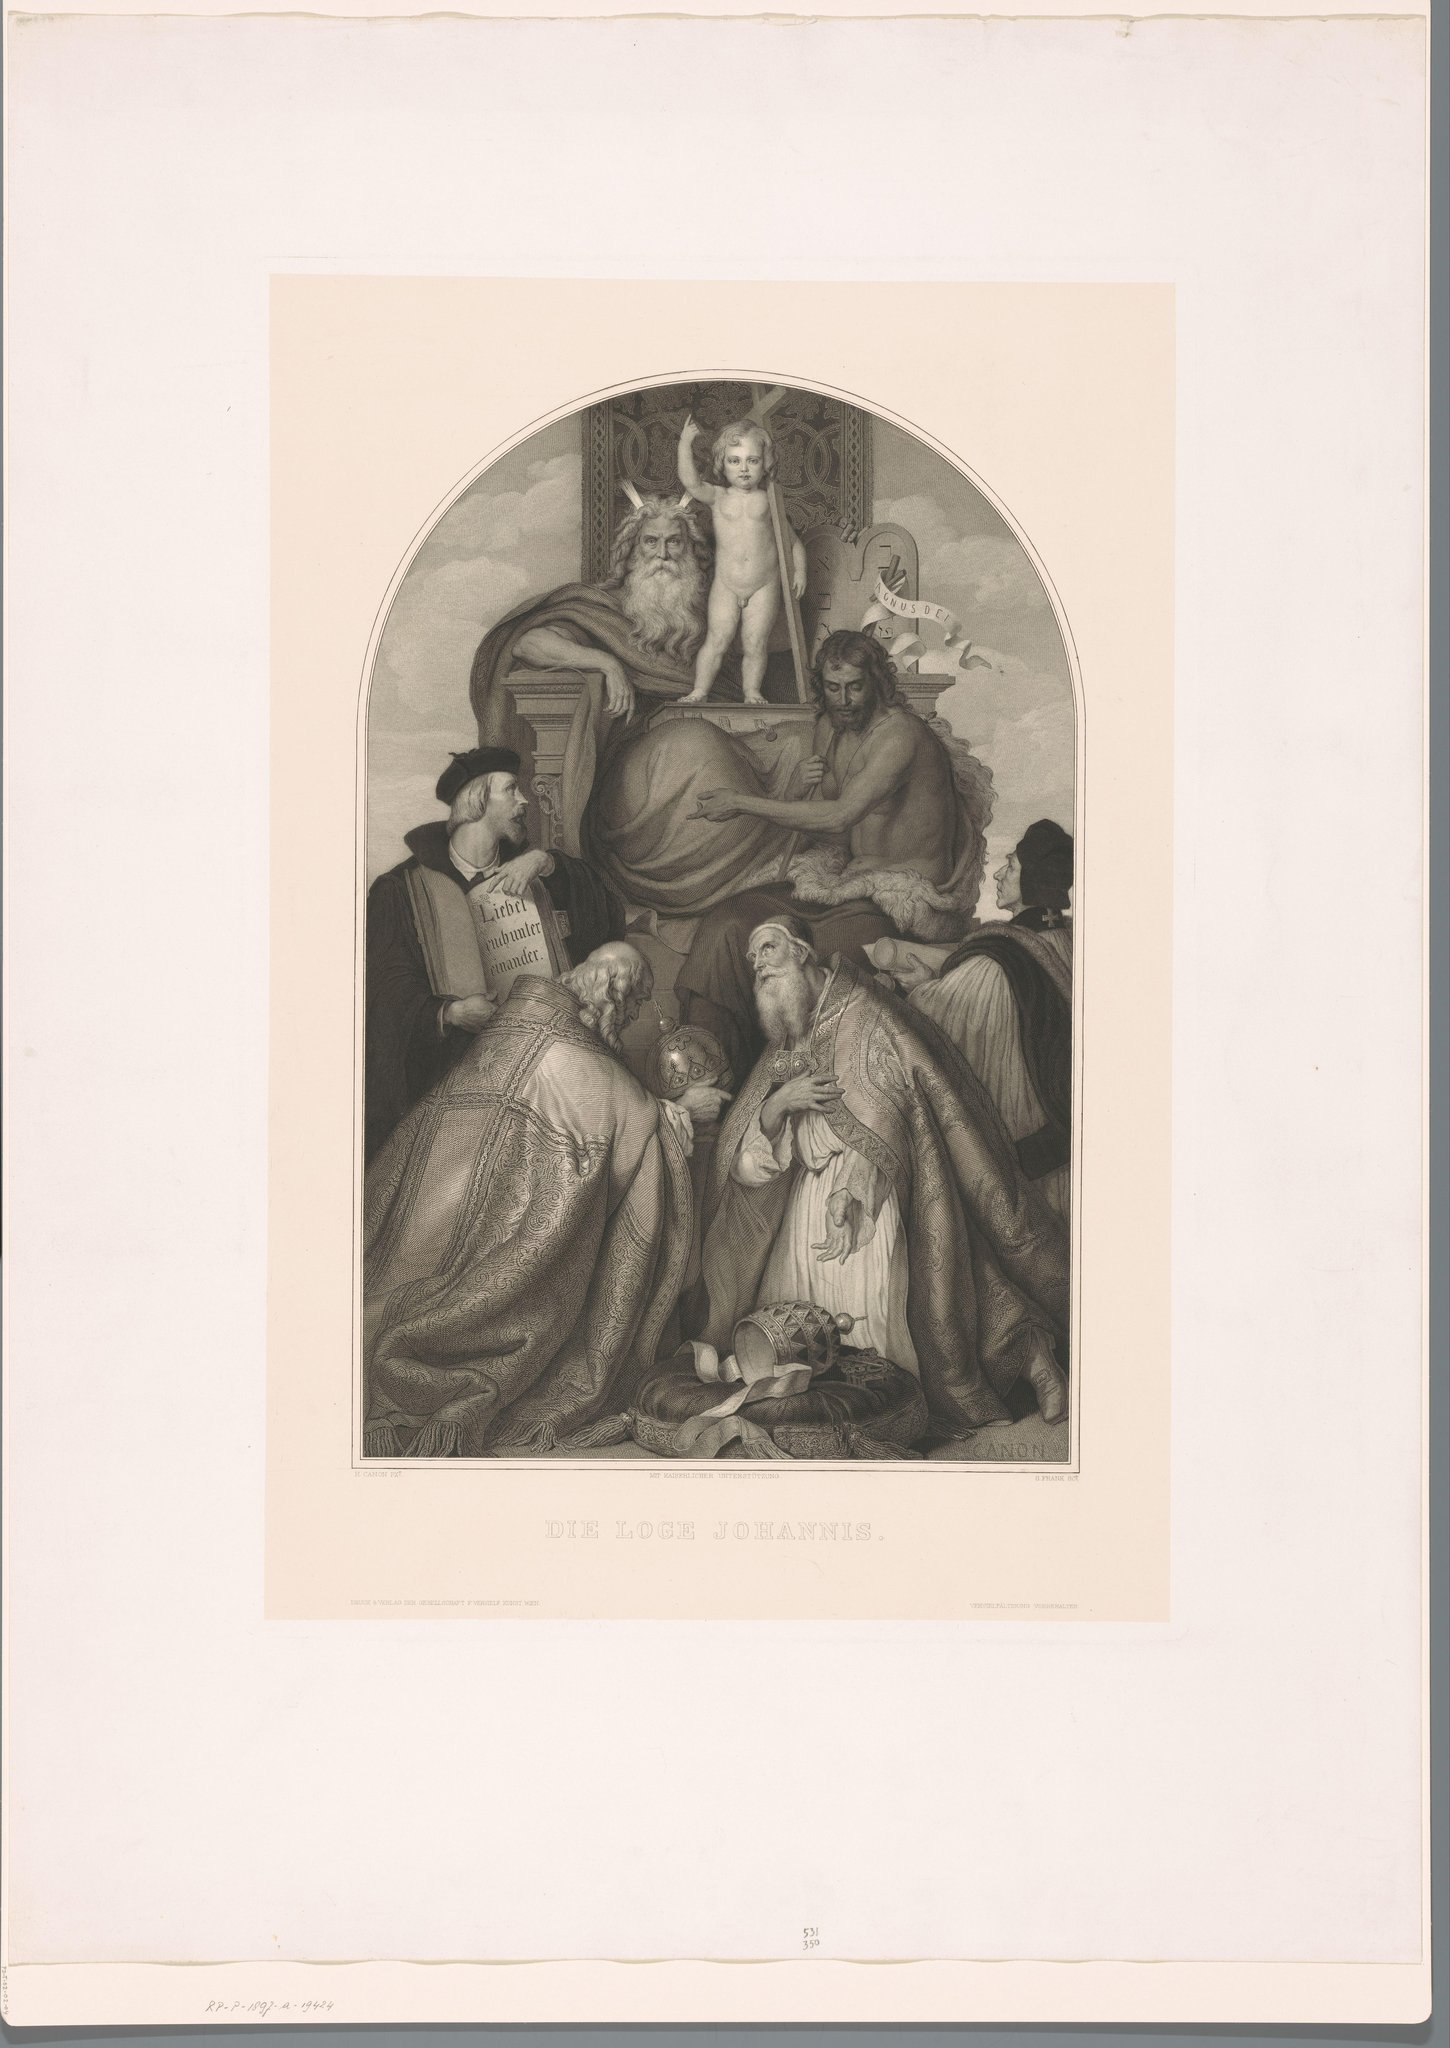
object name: print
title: Christuskind omringd door heiligen en kerkvaders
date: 1869-1913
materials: paper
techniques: engraving, etching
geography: germany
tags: crown (symbol of sovereignty), john the baptist; possible attributes: book, reed cross, baptismal cup, honeycomb, lamb, staff, book, christ-child carrying the cross, royal mantle (symbol of sovereignty)